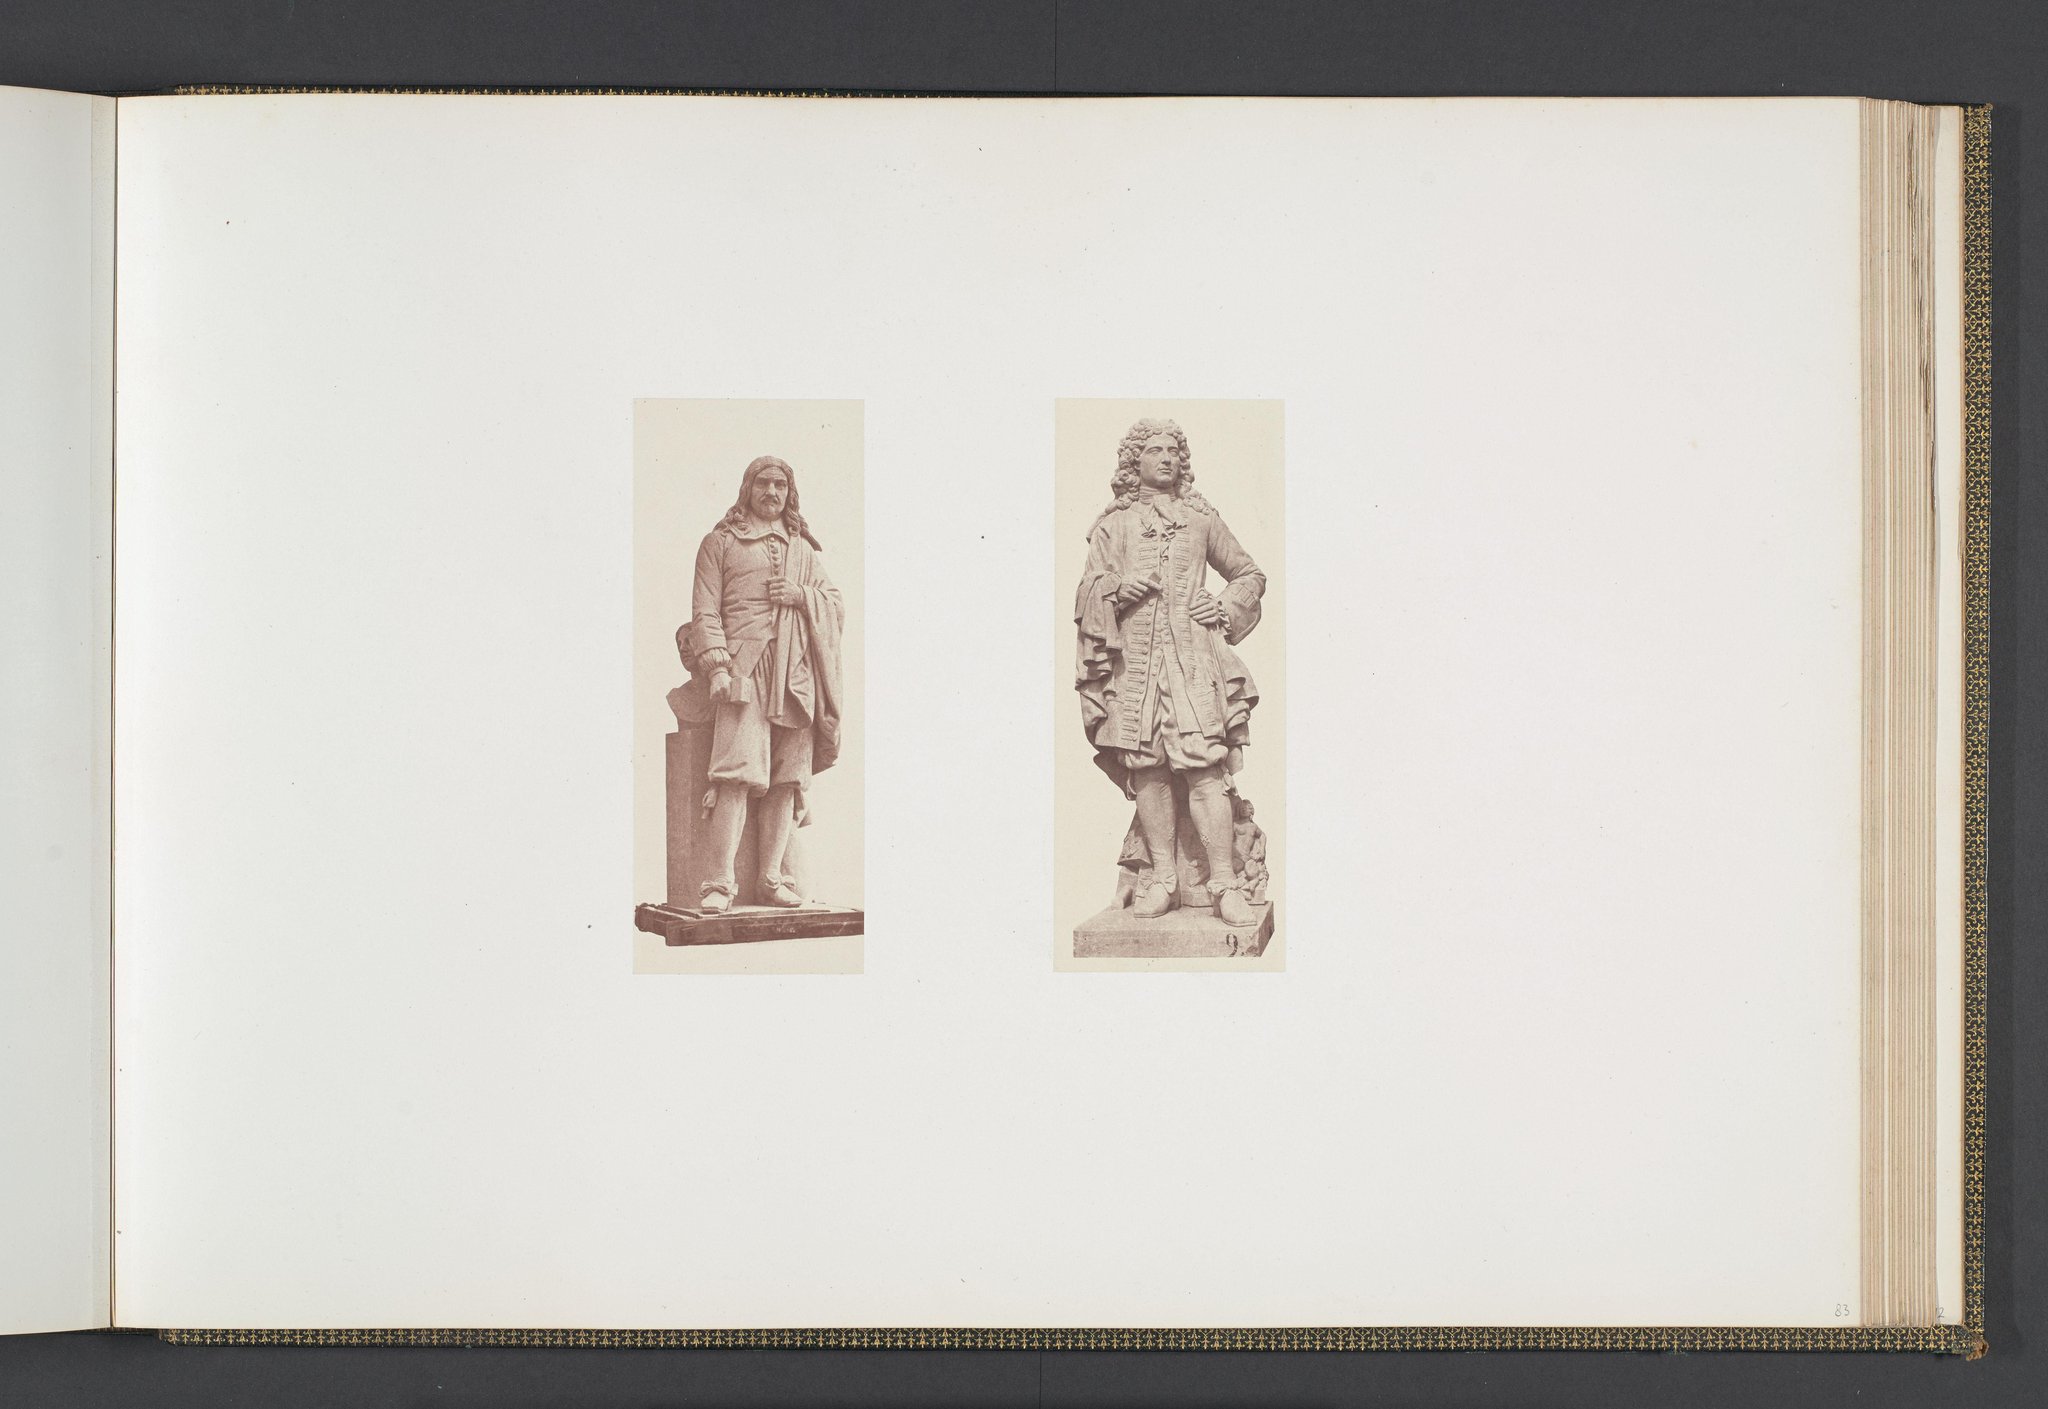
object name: album leaf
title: Gipsmodellen voor beeldhouwwerken op het Palais du Louvre: links "Sarrazin" door Aristide Husson en rechts "Coustou" door Augustin Courtet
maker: édouard denis baldus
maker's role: fotograaf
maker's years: 1813-1889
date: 1855-1857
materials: paper, photographic support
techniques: salted paper print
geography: paris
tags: piece of sculpture, reproduction of a piece of sculpture, permanent exhibition, museum, paris, tuileries palace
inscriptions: number: ‘9 (rechts)’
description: Onderdeel van Réunion des Tuileries au Louvre 1852-1857, album 2.